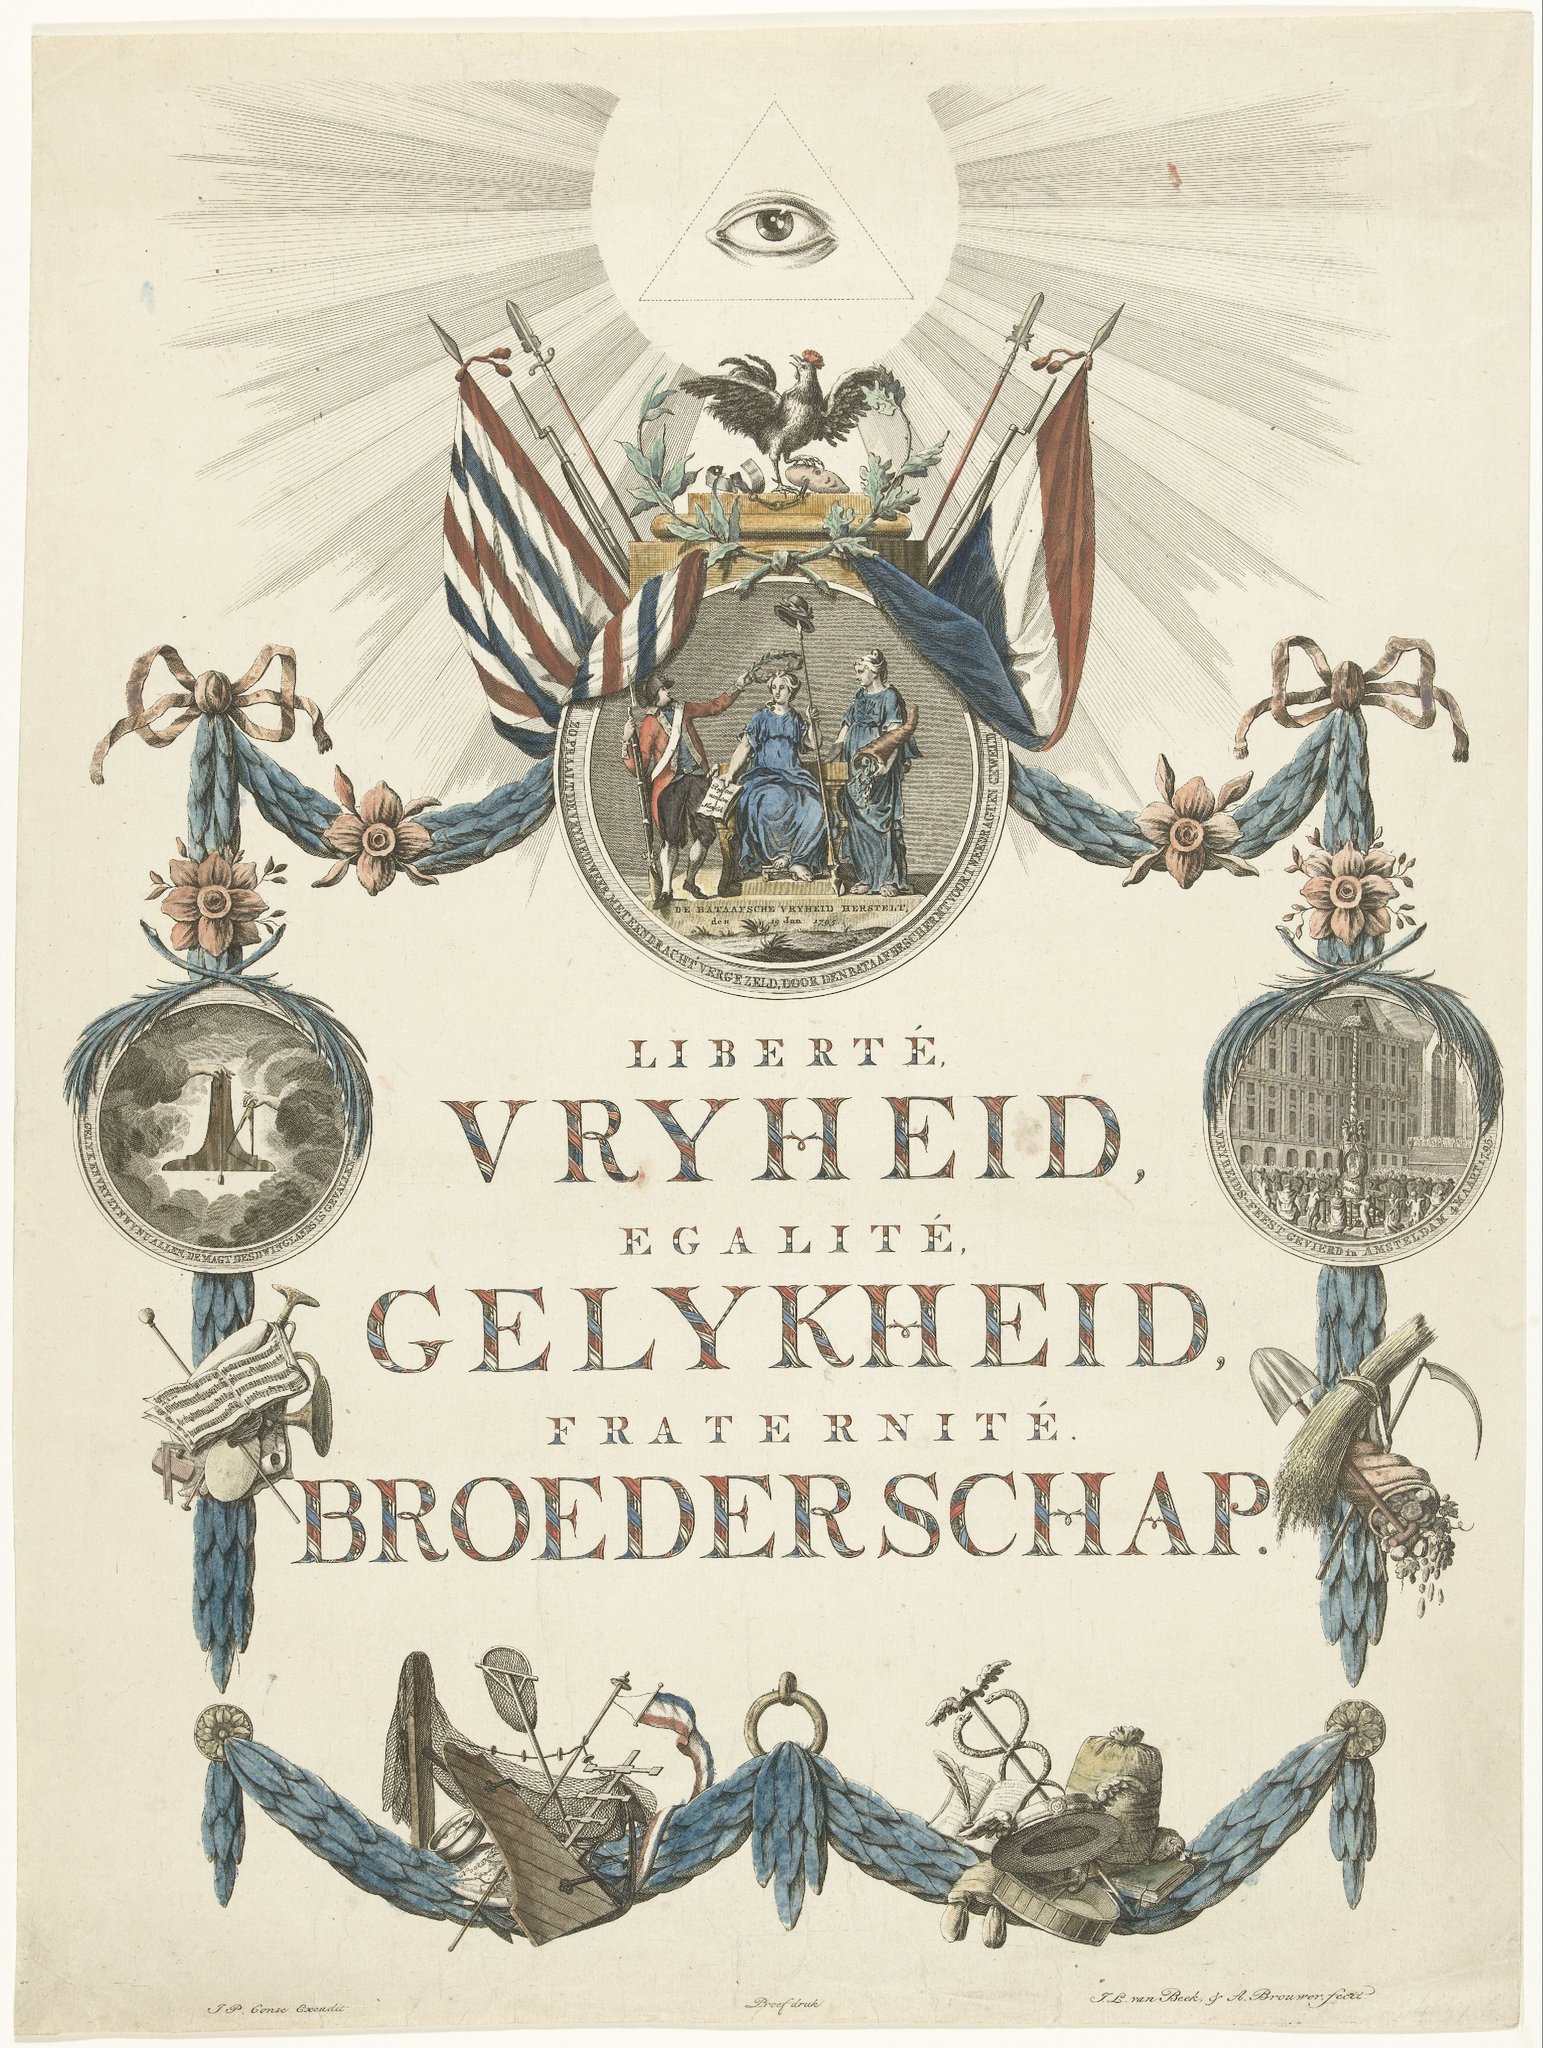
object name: print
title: Liberté Vryheid, Egalité Gelykheid, Fraternité Broederschap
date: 1795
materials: paper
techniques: brush, engraving, etching, hand coloring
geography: netherlands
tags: the all-seeing eye, triangle with eye ~ symbol of god the father, freedom, liberty; 'libertà' (ripa) (+ abstract concept represented by female figure), equality, equity, fairness, righteousness; 'equalità', 'equità', 'giuditio giusto', 'ordine dritto e giusto', 'ugualità' (ripa) (+ symbolical representation of concept), dancing around the tree of liberty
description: Gedenkplaat met tekst en een ornamentele omlijsting met drie medaillons. Boven: de personificatie van de vrijheid wordt gelauwerd door een Franse soldaat. Rechts een medaillon met het oprichten van de vrijheidsboom in Amsterdam, links een medaillon met een passer en een meetinstrument. In de omlijsting zijn symbolen voor de schone kunsten, de zeevaart, de handel en de landbouw.